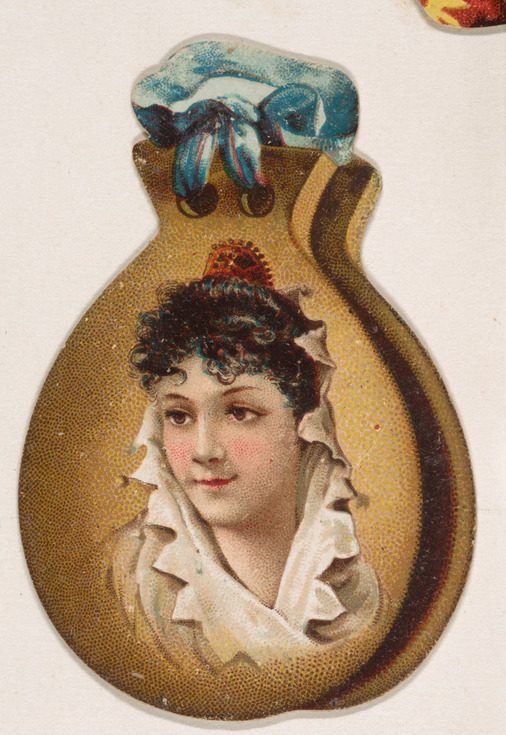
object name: print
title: Castanets, from the Novelties series (N228, Type 3) issued by Kinney Bros.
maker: kinney brothers tobacco company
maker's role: publisher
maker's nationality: american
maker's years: 1869-2011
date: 1889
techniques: color lithograph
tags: women